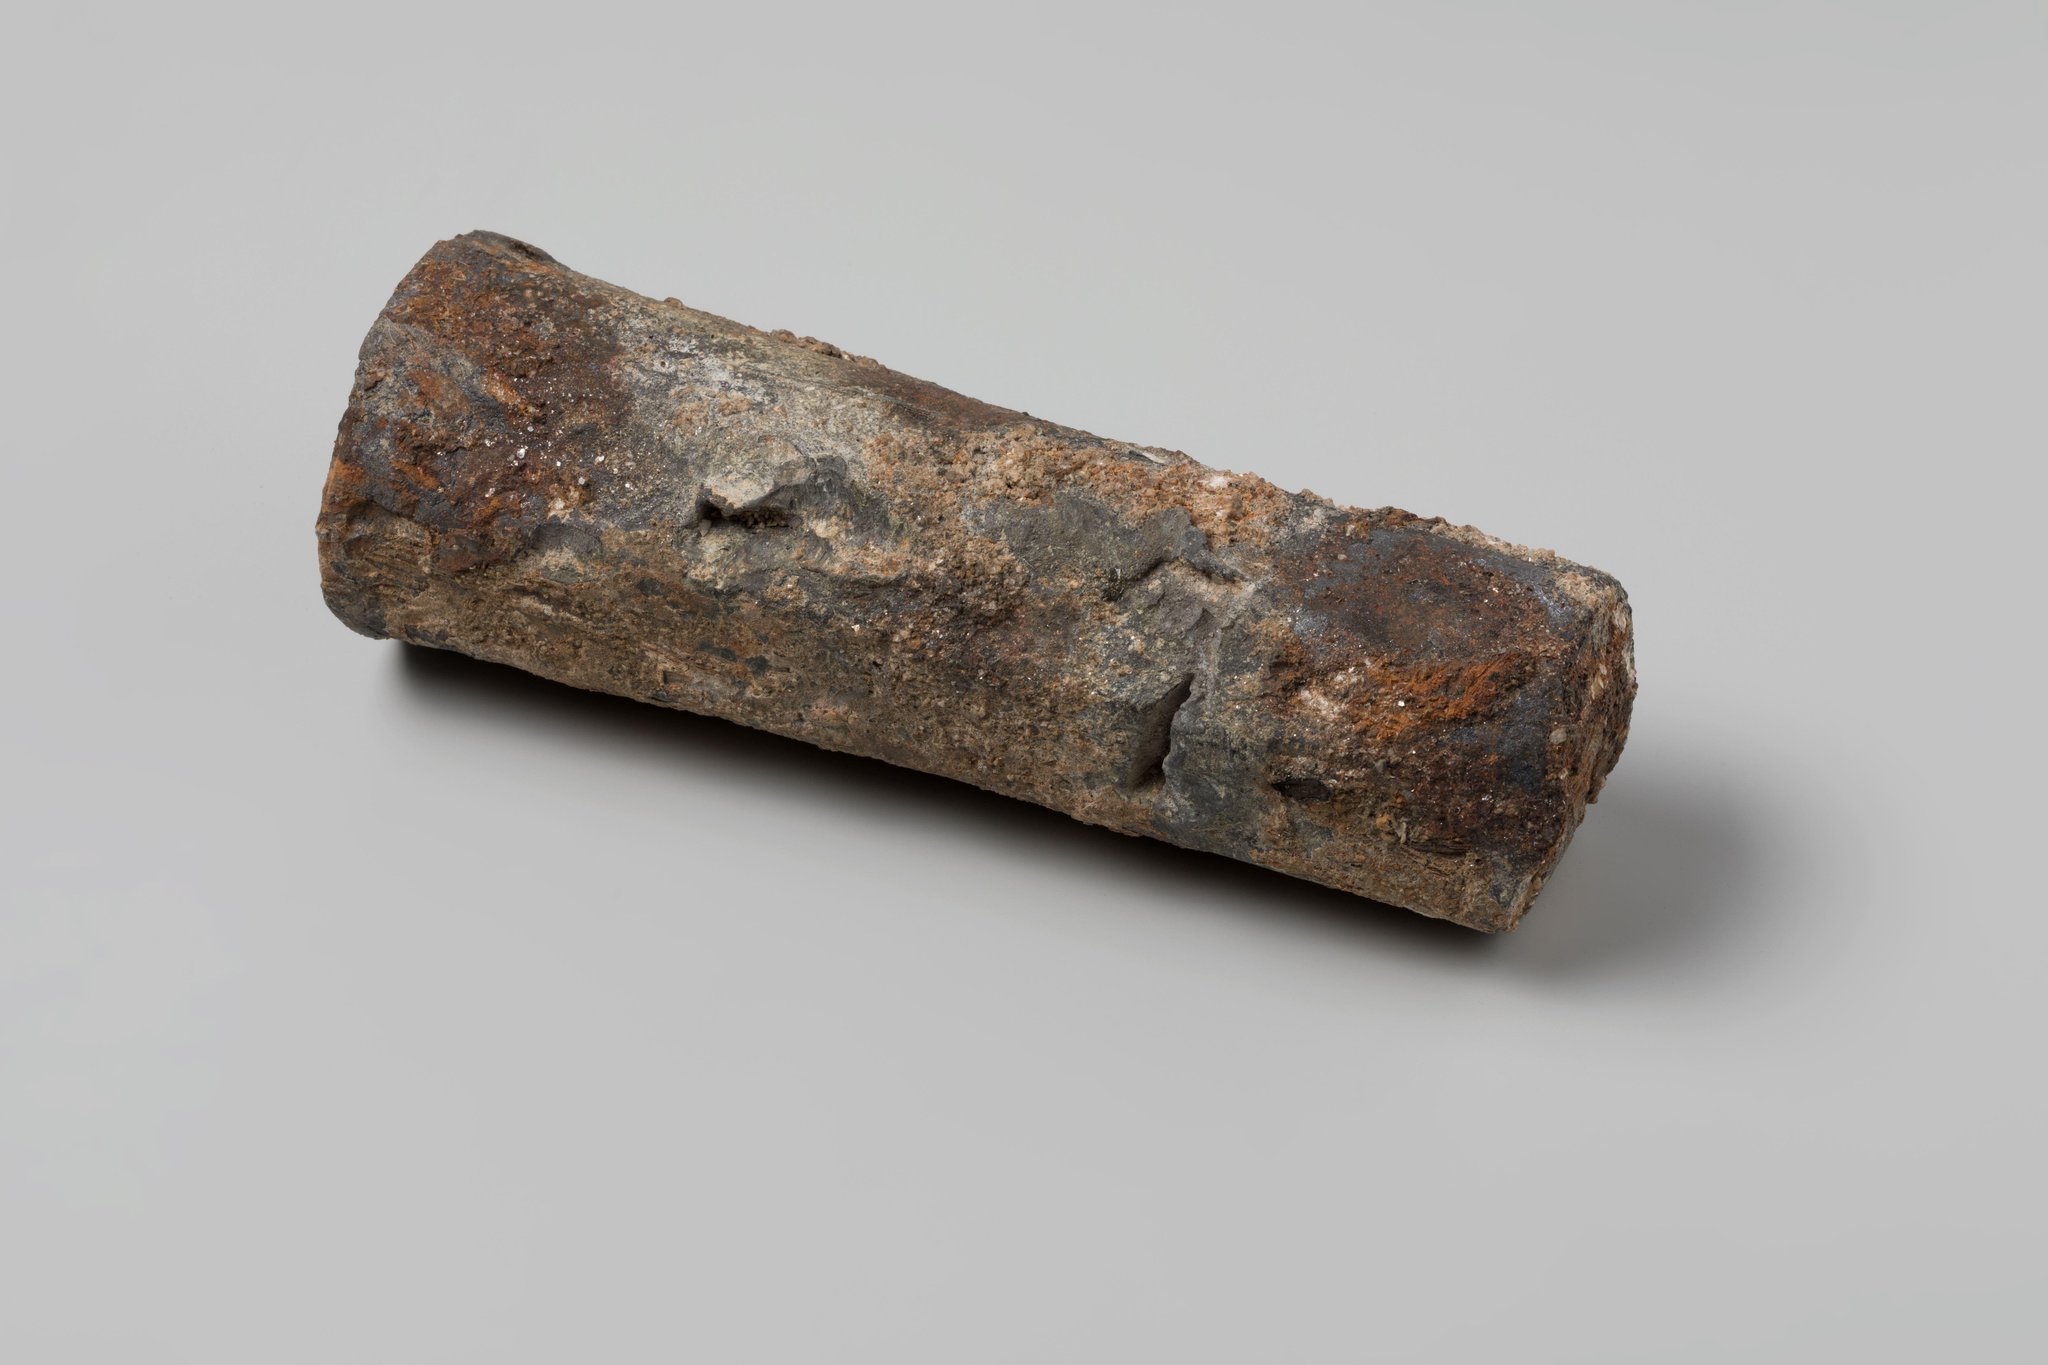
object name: sounding lead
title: Dieplood uit het wrak van de Oost-Indiëvaarder Hollandia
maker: Anonymous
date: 1700-1743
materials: lead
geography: netherlands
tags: verenigde oostindische compagnie, hollandia (schip), annet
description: Tools and instruments, navigation, sounding lead; fragm, base, cut off: octagonal faceted, tapering upwards, domed cavity in underside, inscription on side [XXX], encrusted.